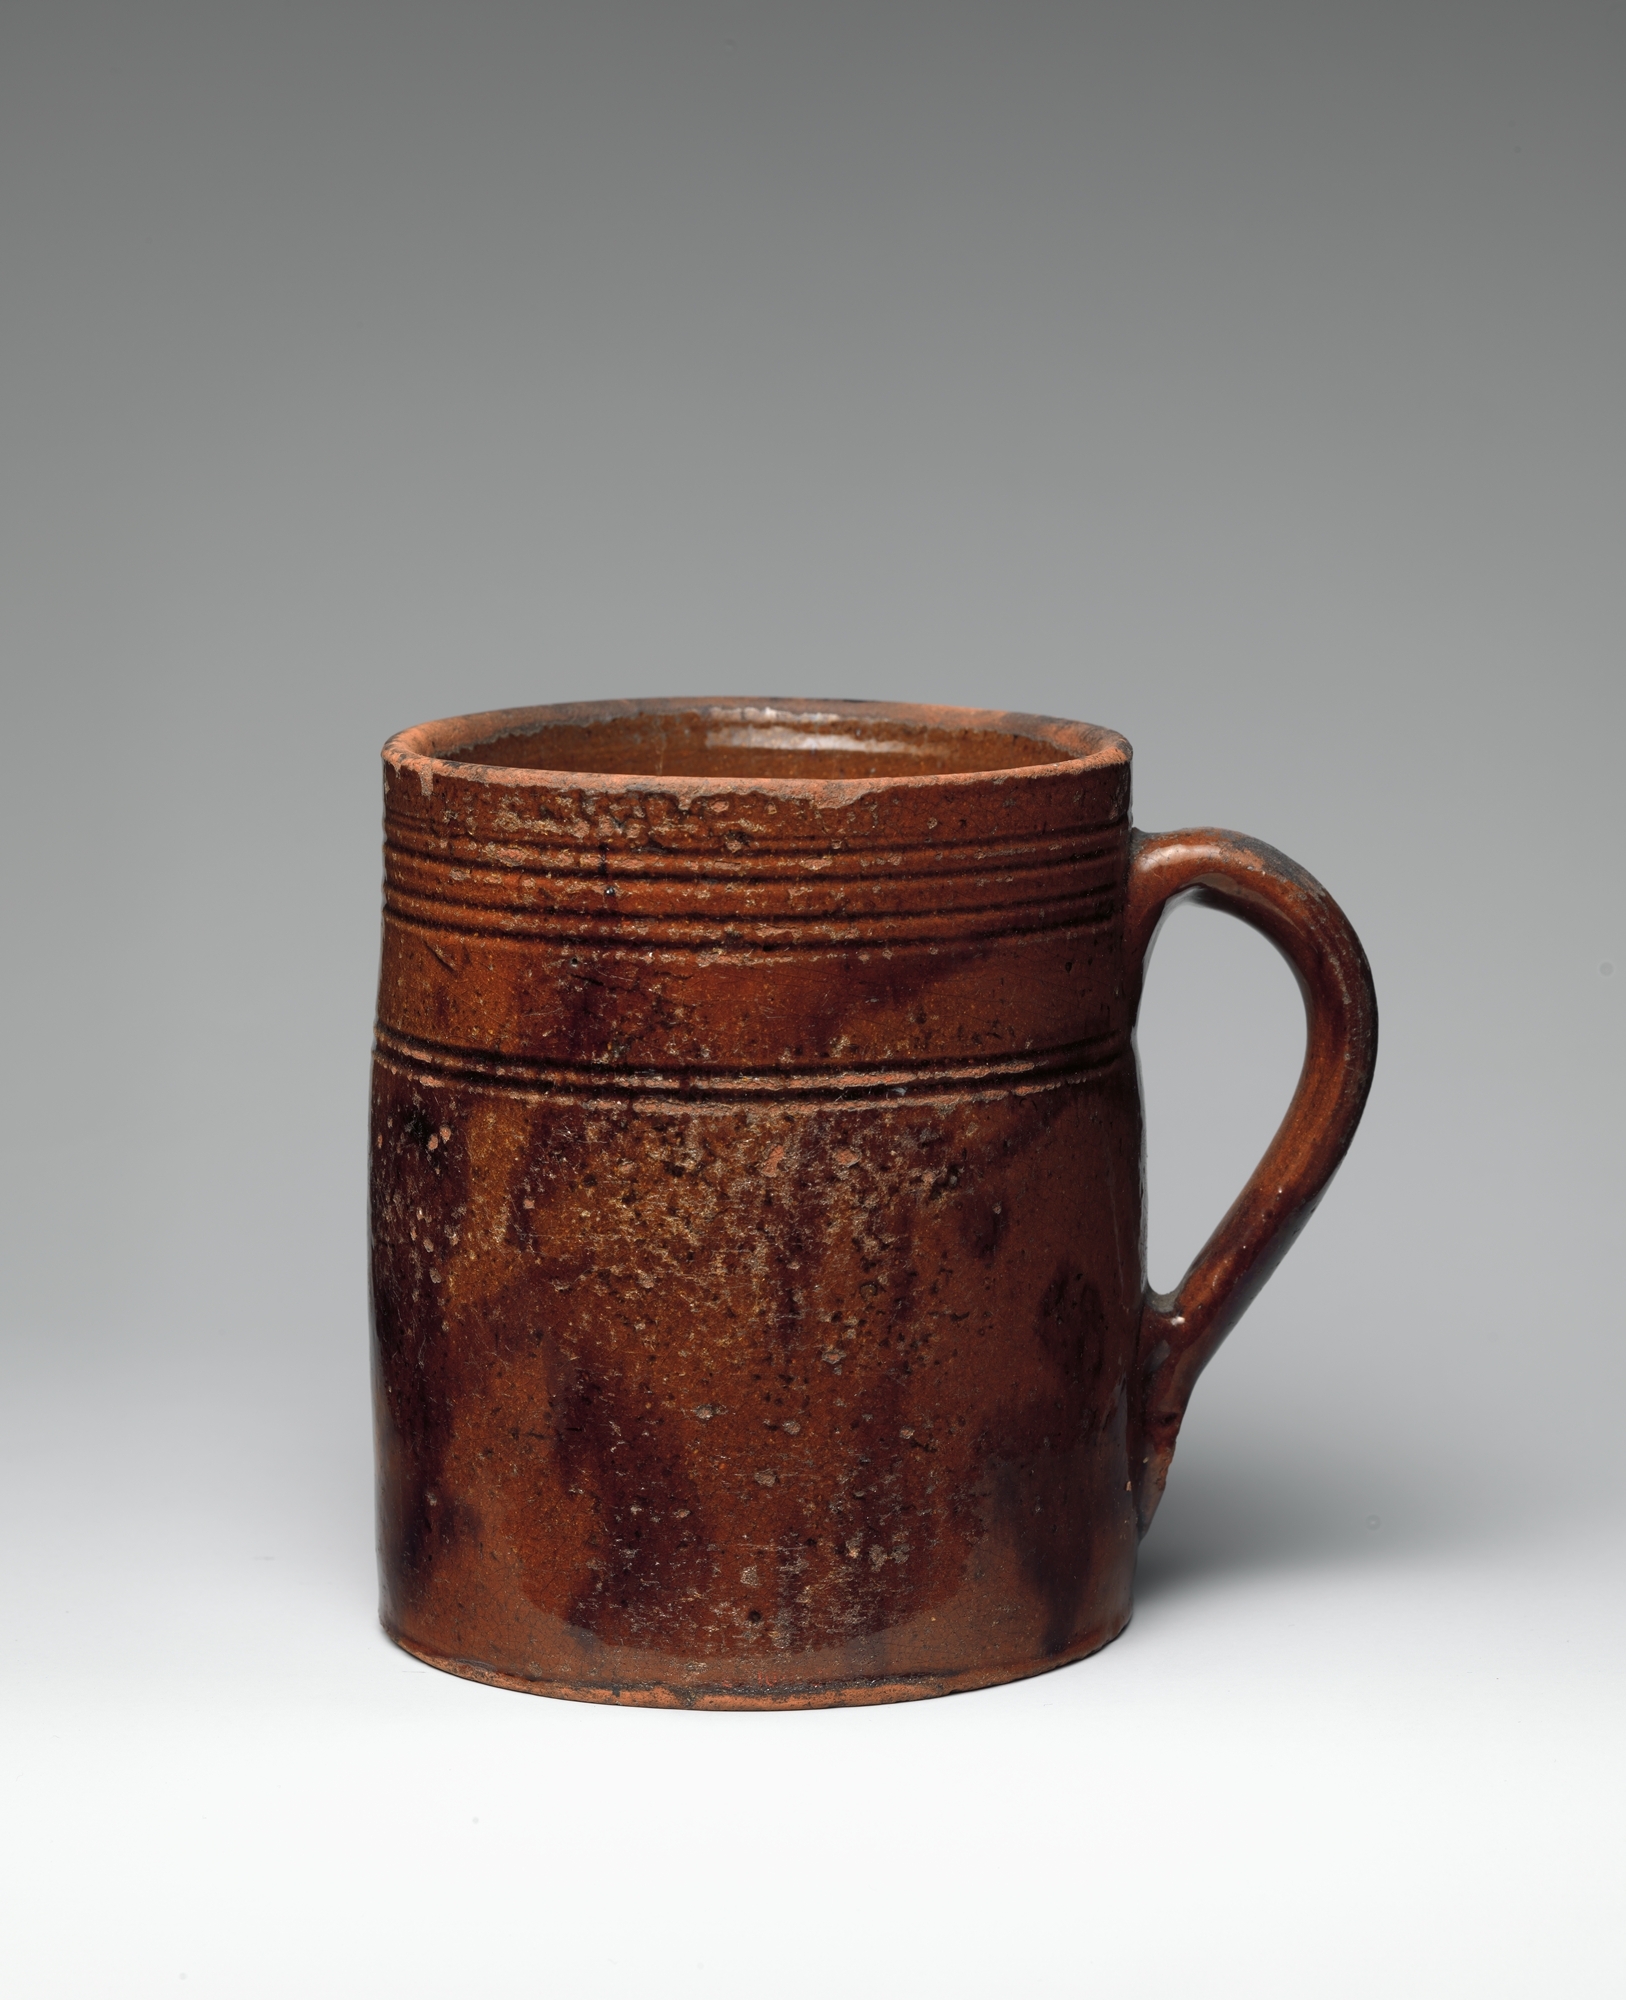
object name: mug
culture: american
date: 1800-1830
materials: earthenware